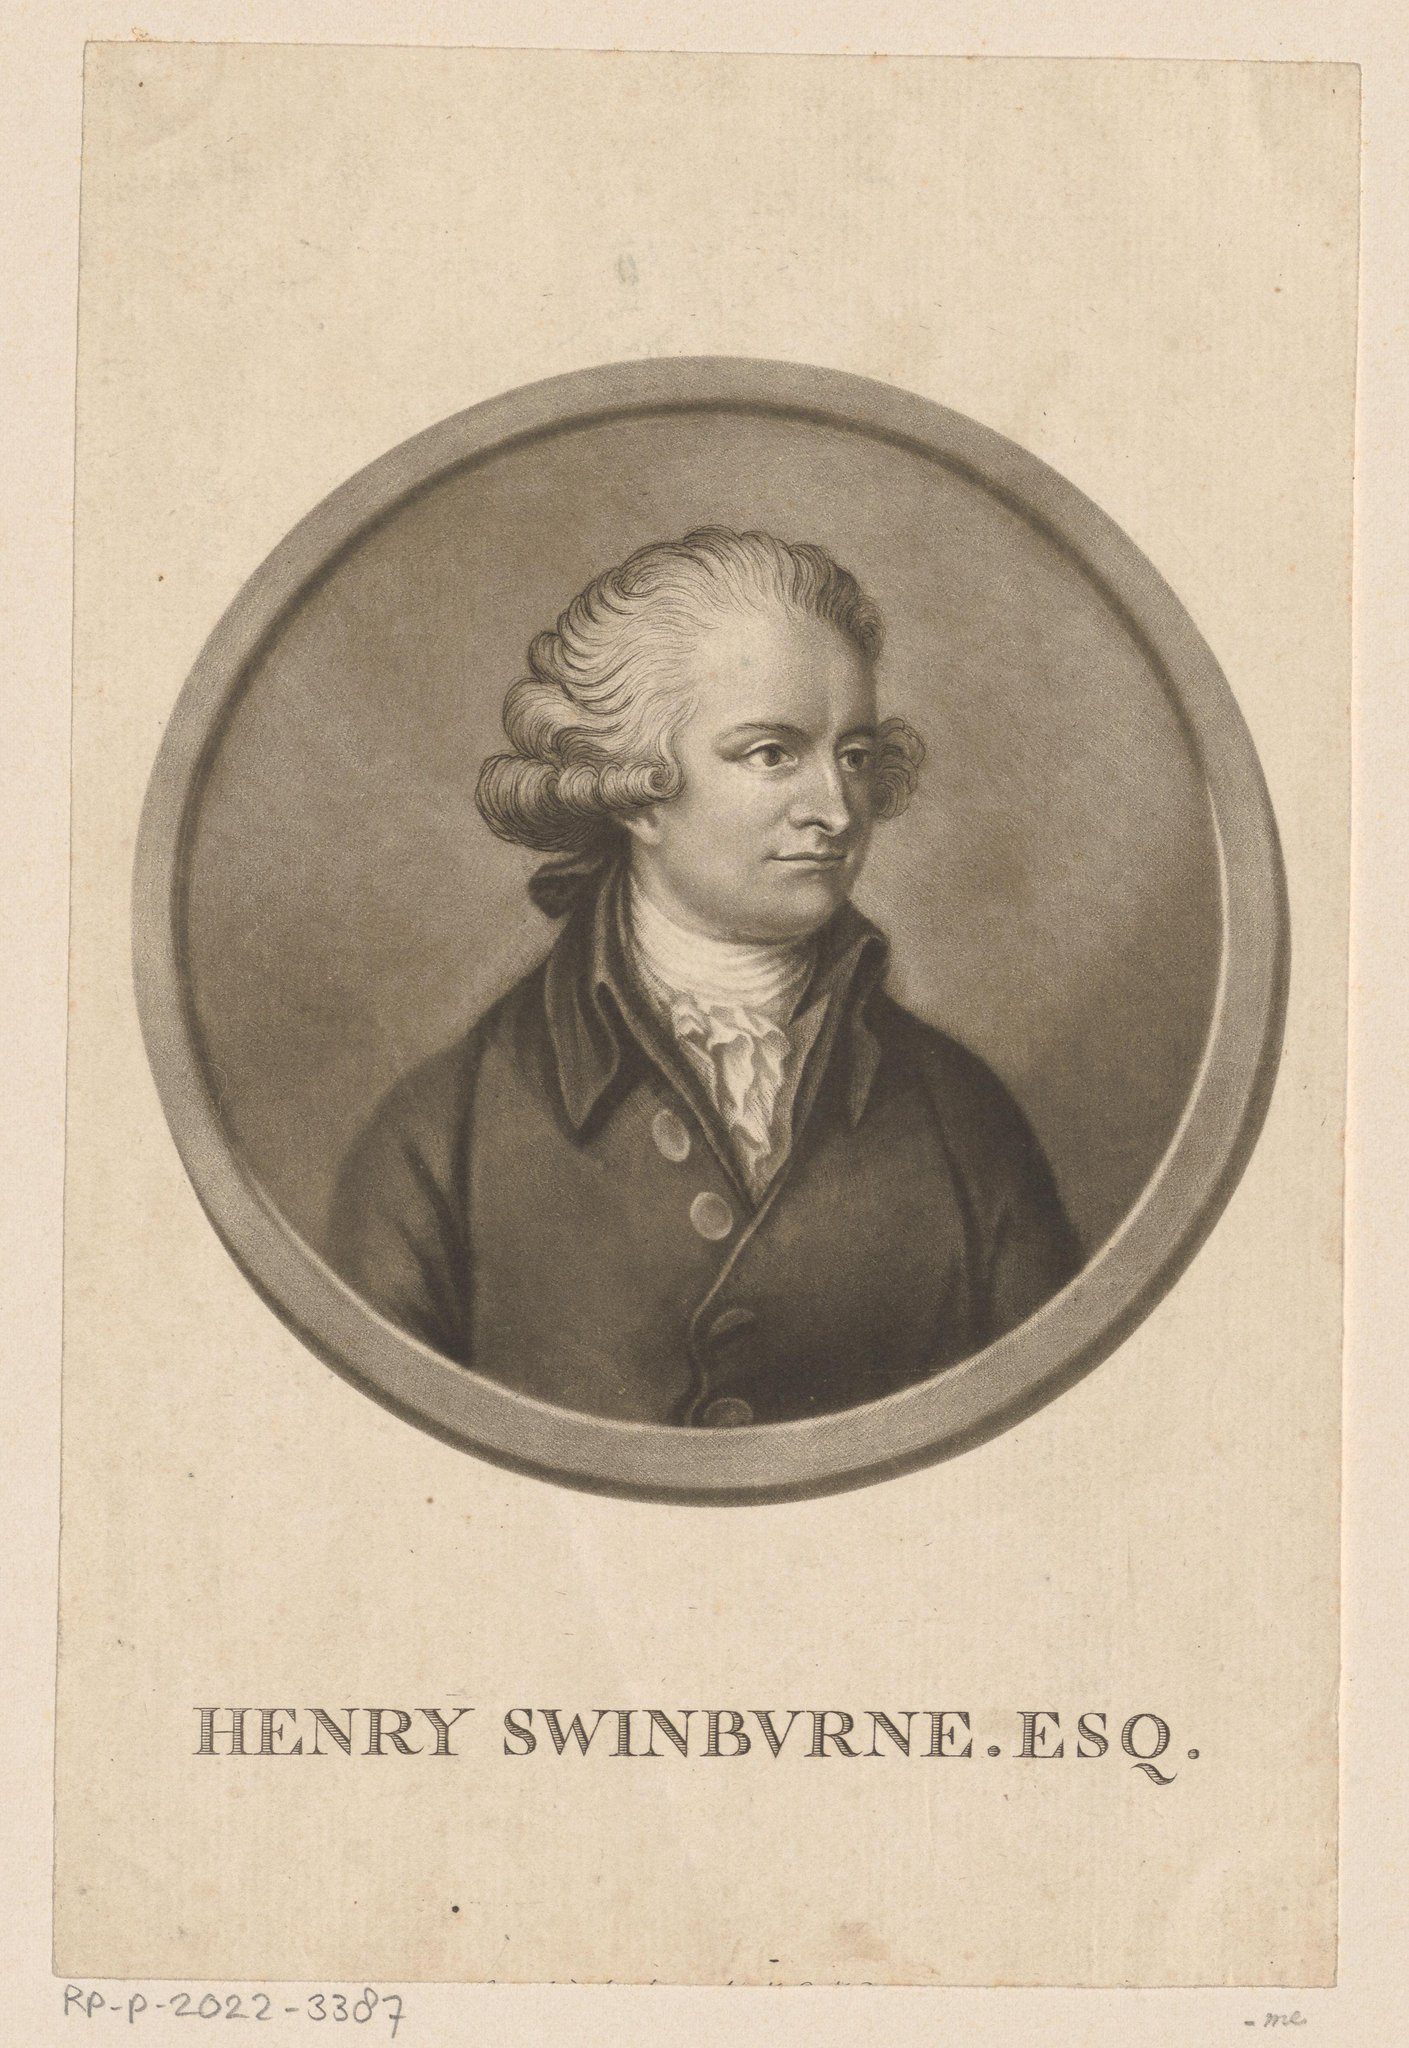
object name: print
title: Portret van Henry Swinburne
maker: johann elias haid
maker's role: print maker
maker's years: 1739-1809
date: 1752-1821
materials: paper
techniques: etching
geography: augsburg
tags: draughtsman, henry swinburne, historical persons, portrait of a writer